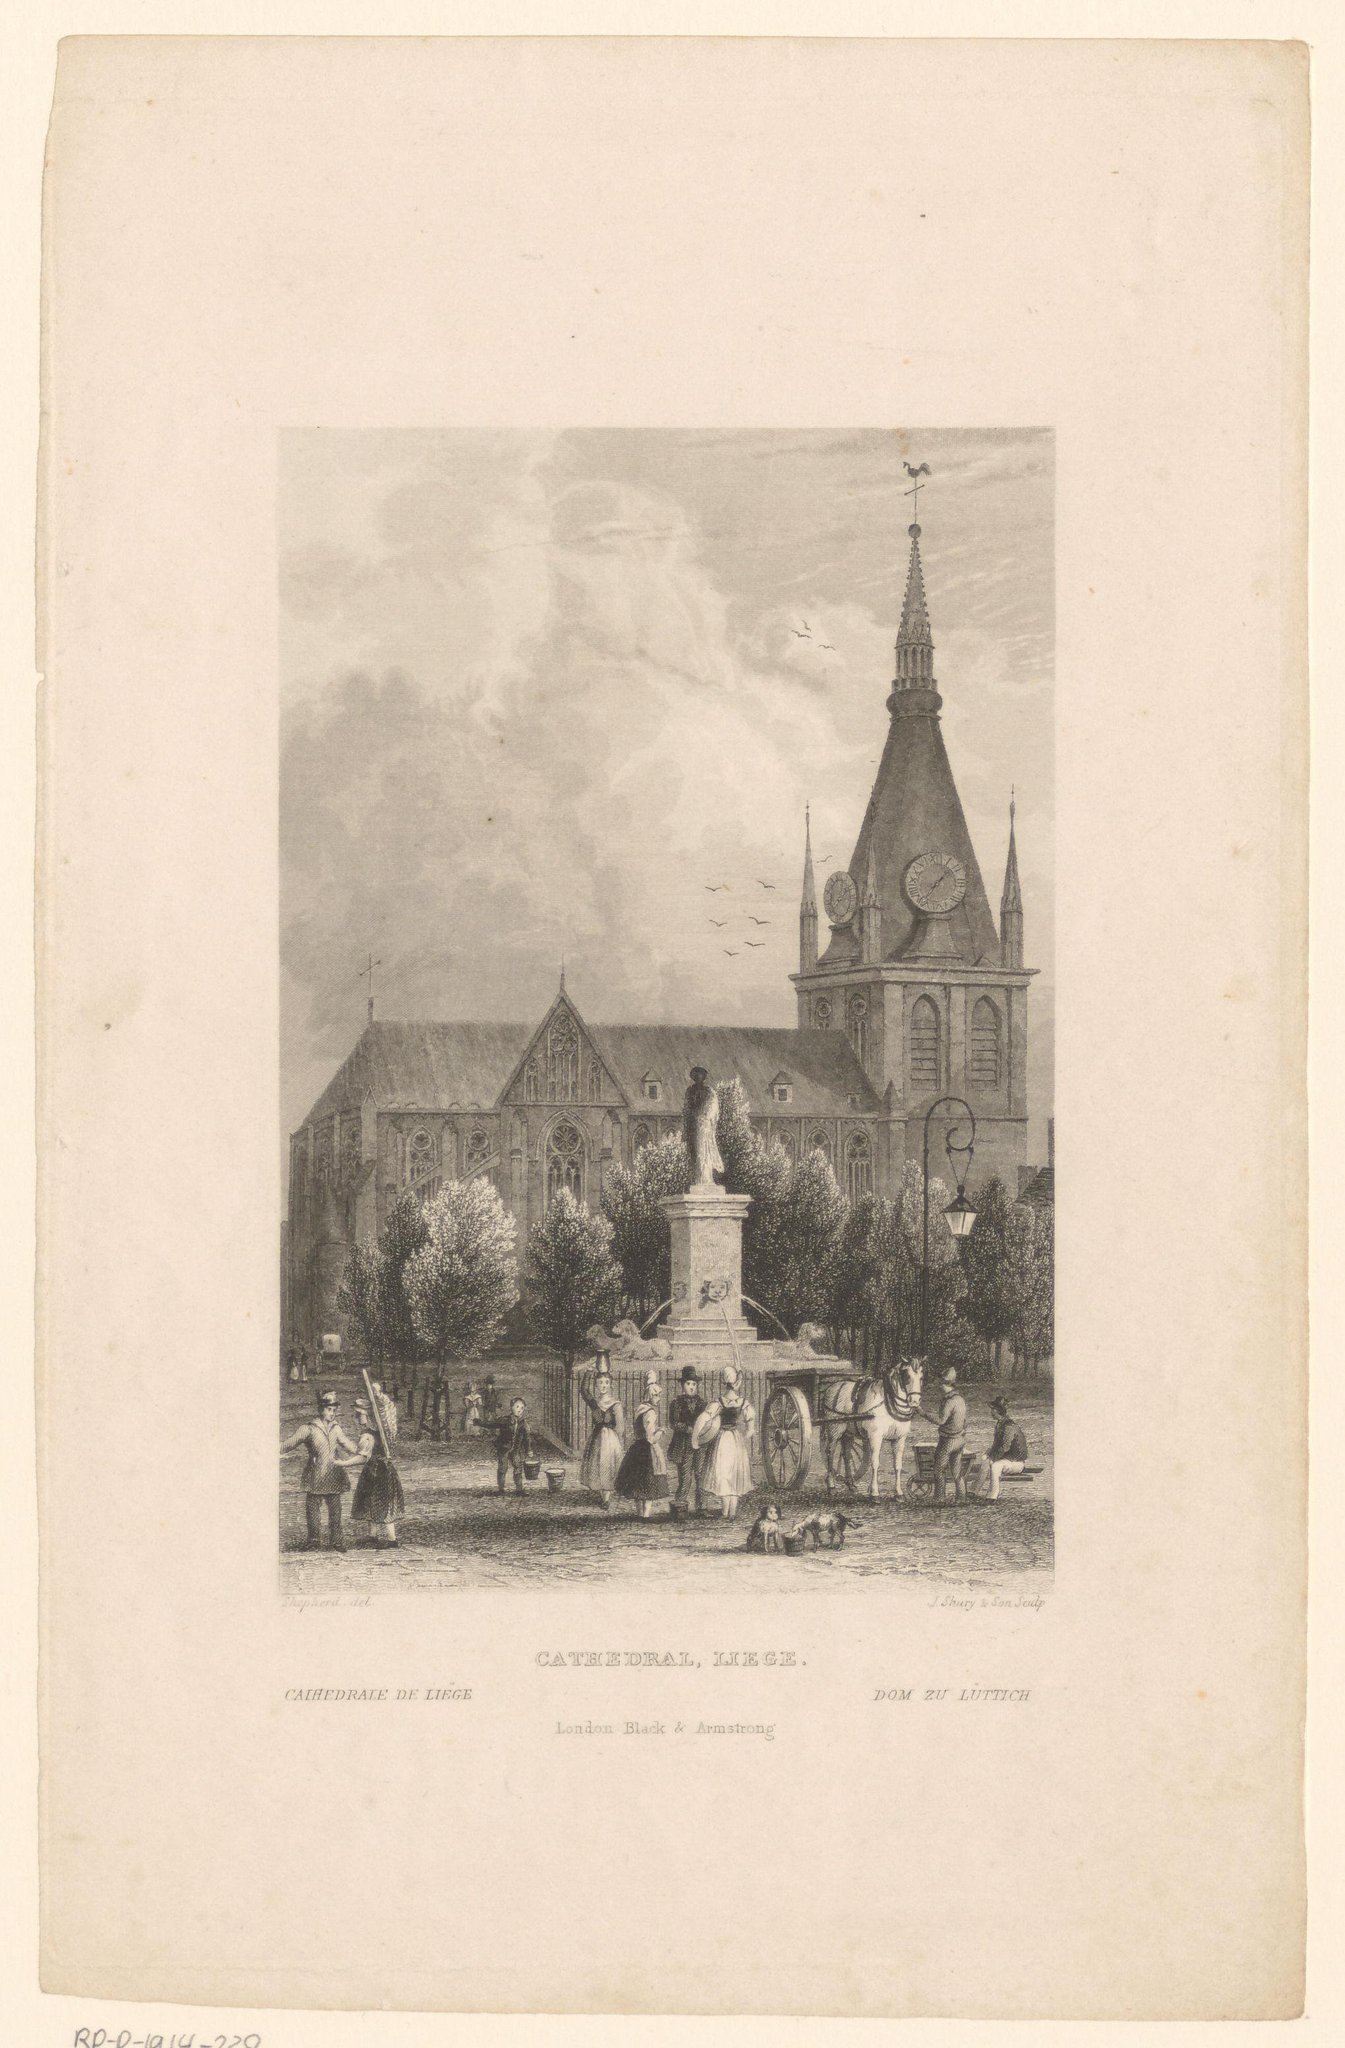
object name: print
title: Gezicht op de Sint-Pauluskathedraal te Luik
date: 1838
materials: paper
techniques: etching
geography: london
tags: church (exterior)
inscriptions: collector's mark: Lugt 2233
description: Prent uit: Belgium and Nassau; or, The continental Tourist. Londen: Black & Armstrong, 1838.